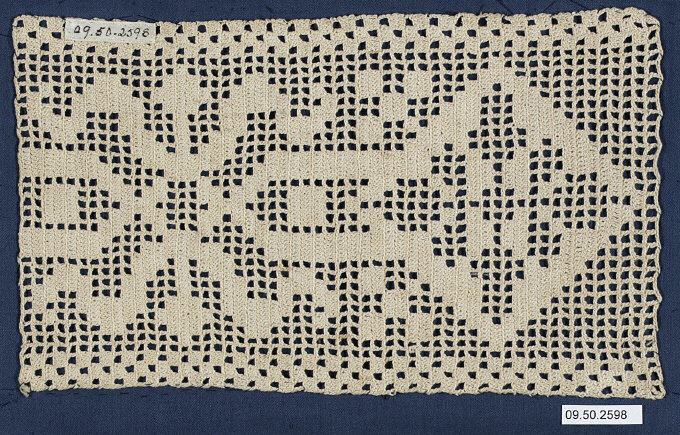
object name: border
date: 1801-1900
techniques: crochet